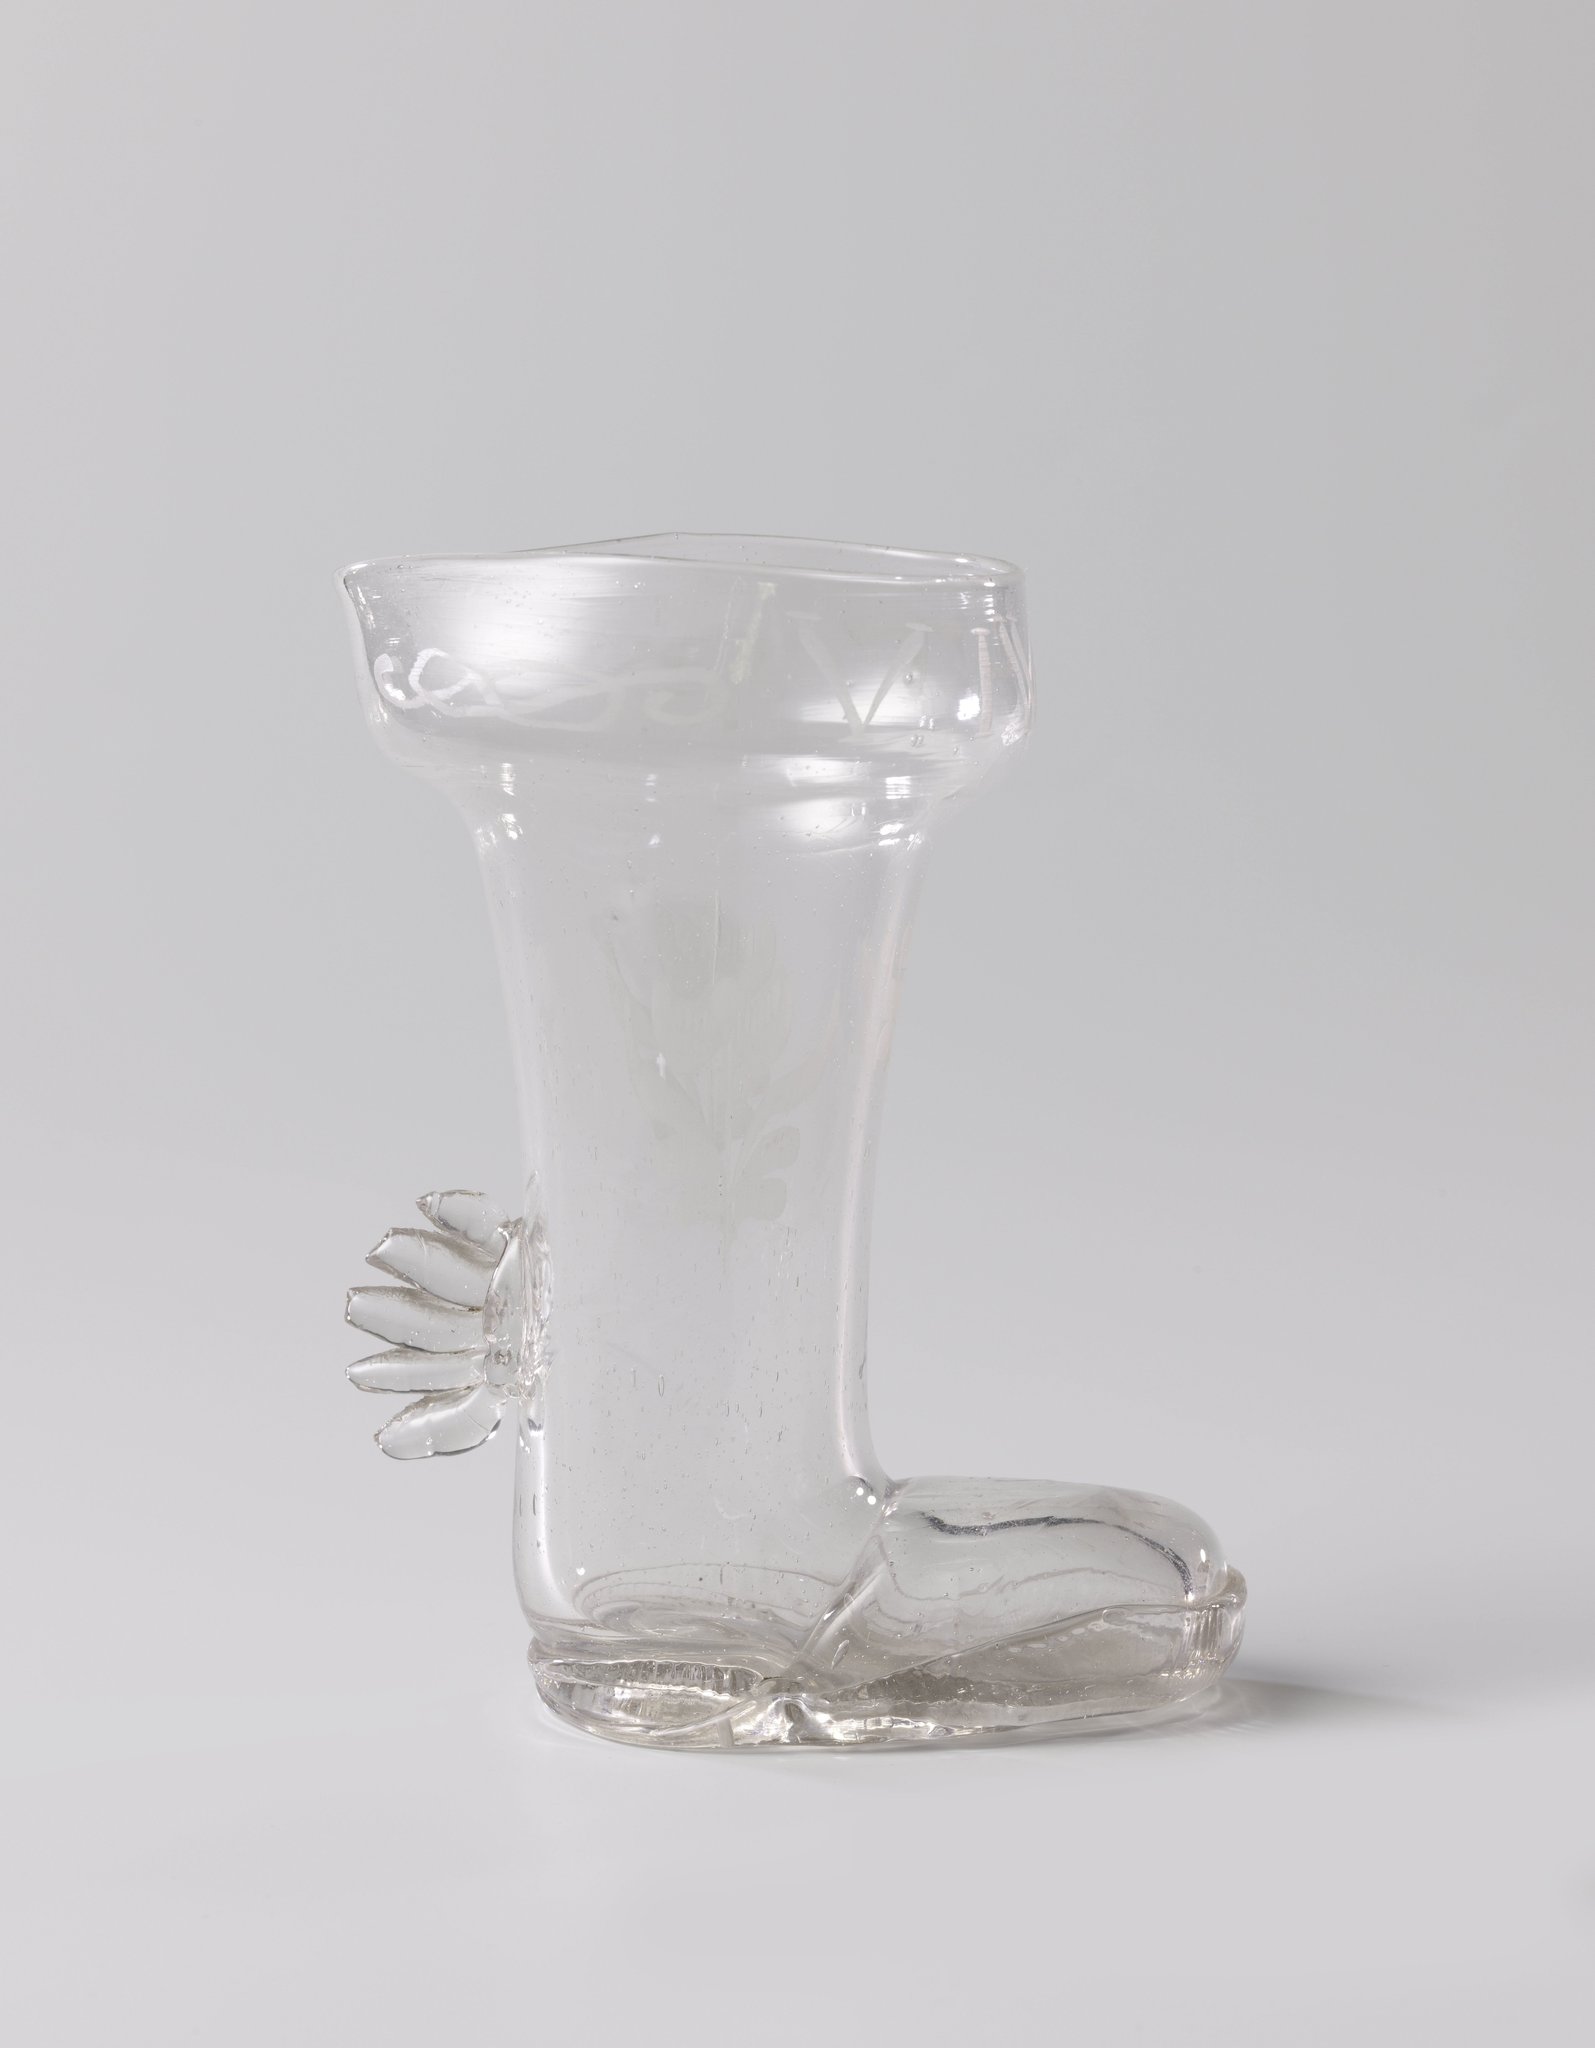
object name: trick glass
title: Glas in de vorm van een rijlaars met het opschrift VIVAT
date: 1700-1800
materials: glass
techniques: glassblowing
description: Dikke platte zool met geribde rand. Stompe neus. Hoge schacht, uitlopend in een wijde kap. Aan de achterzijde een radspoor. Op de schacht zijn met het rad drie bloemtakken gegraveerd en op de kap VIVAT.